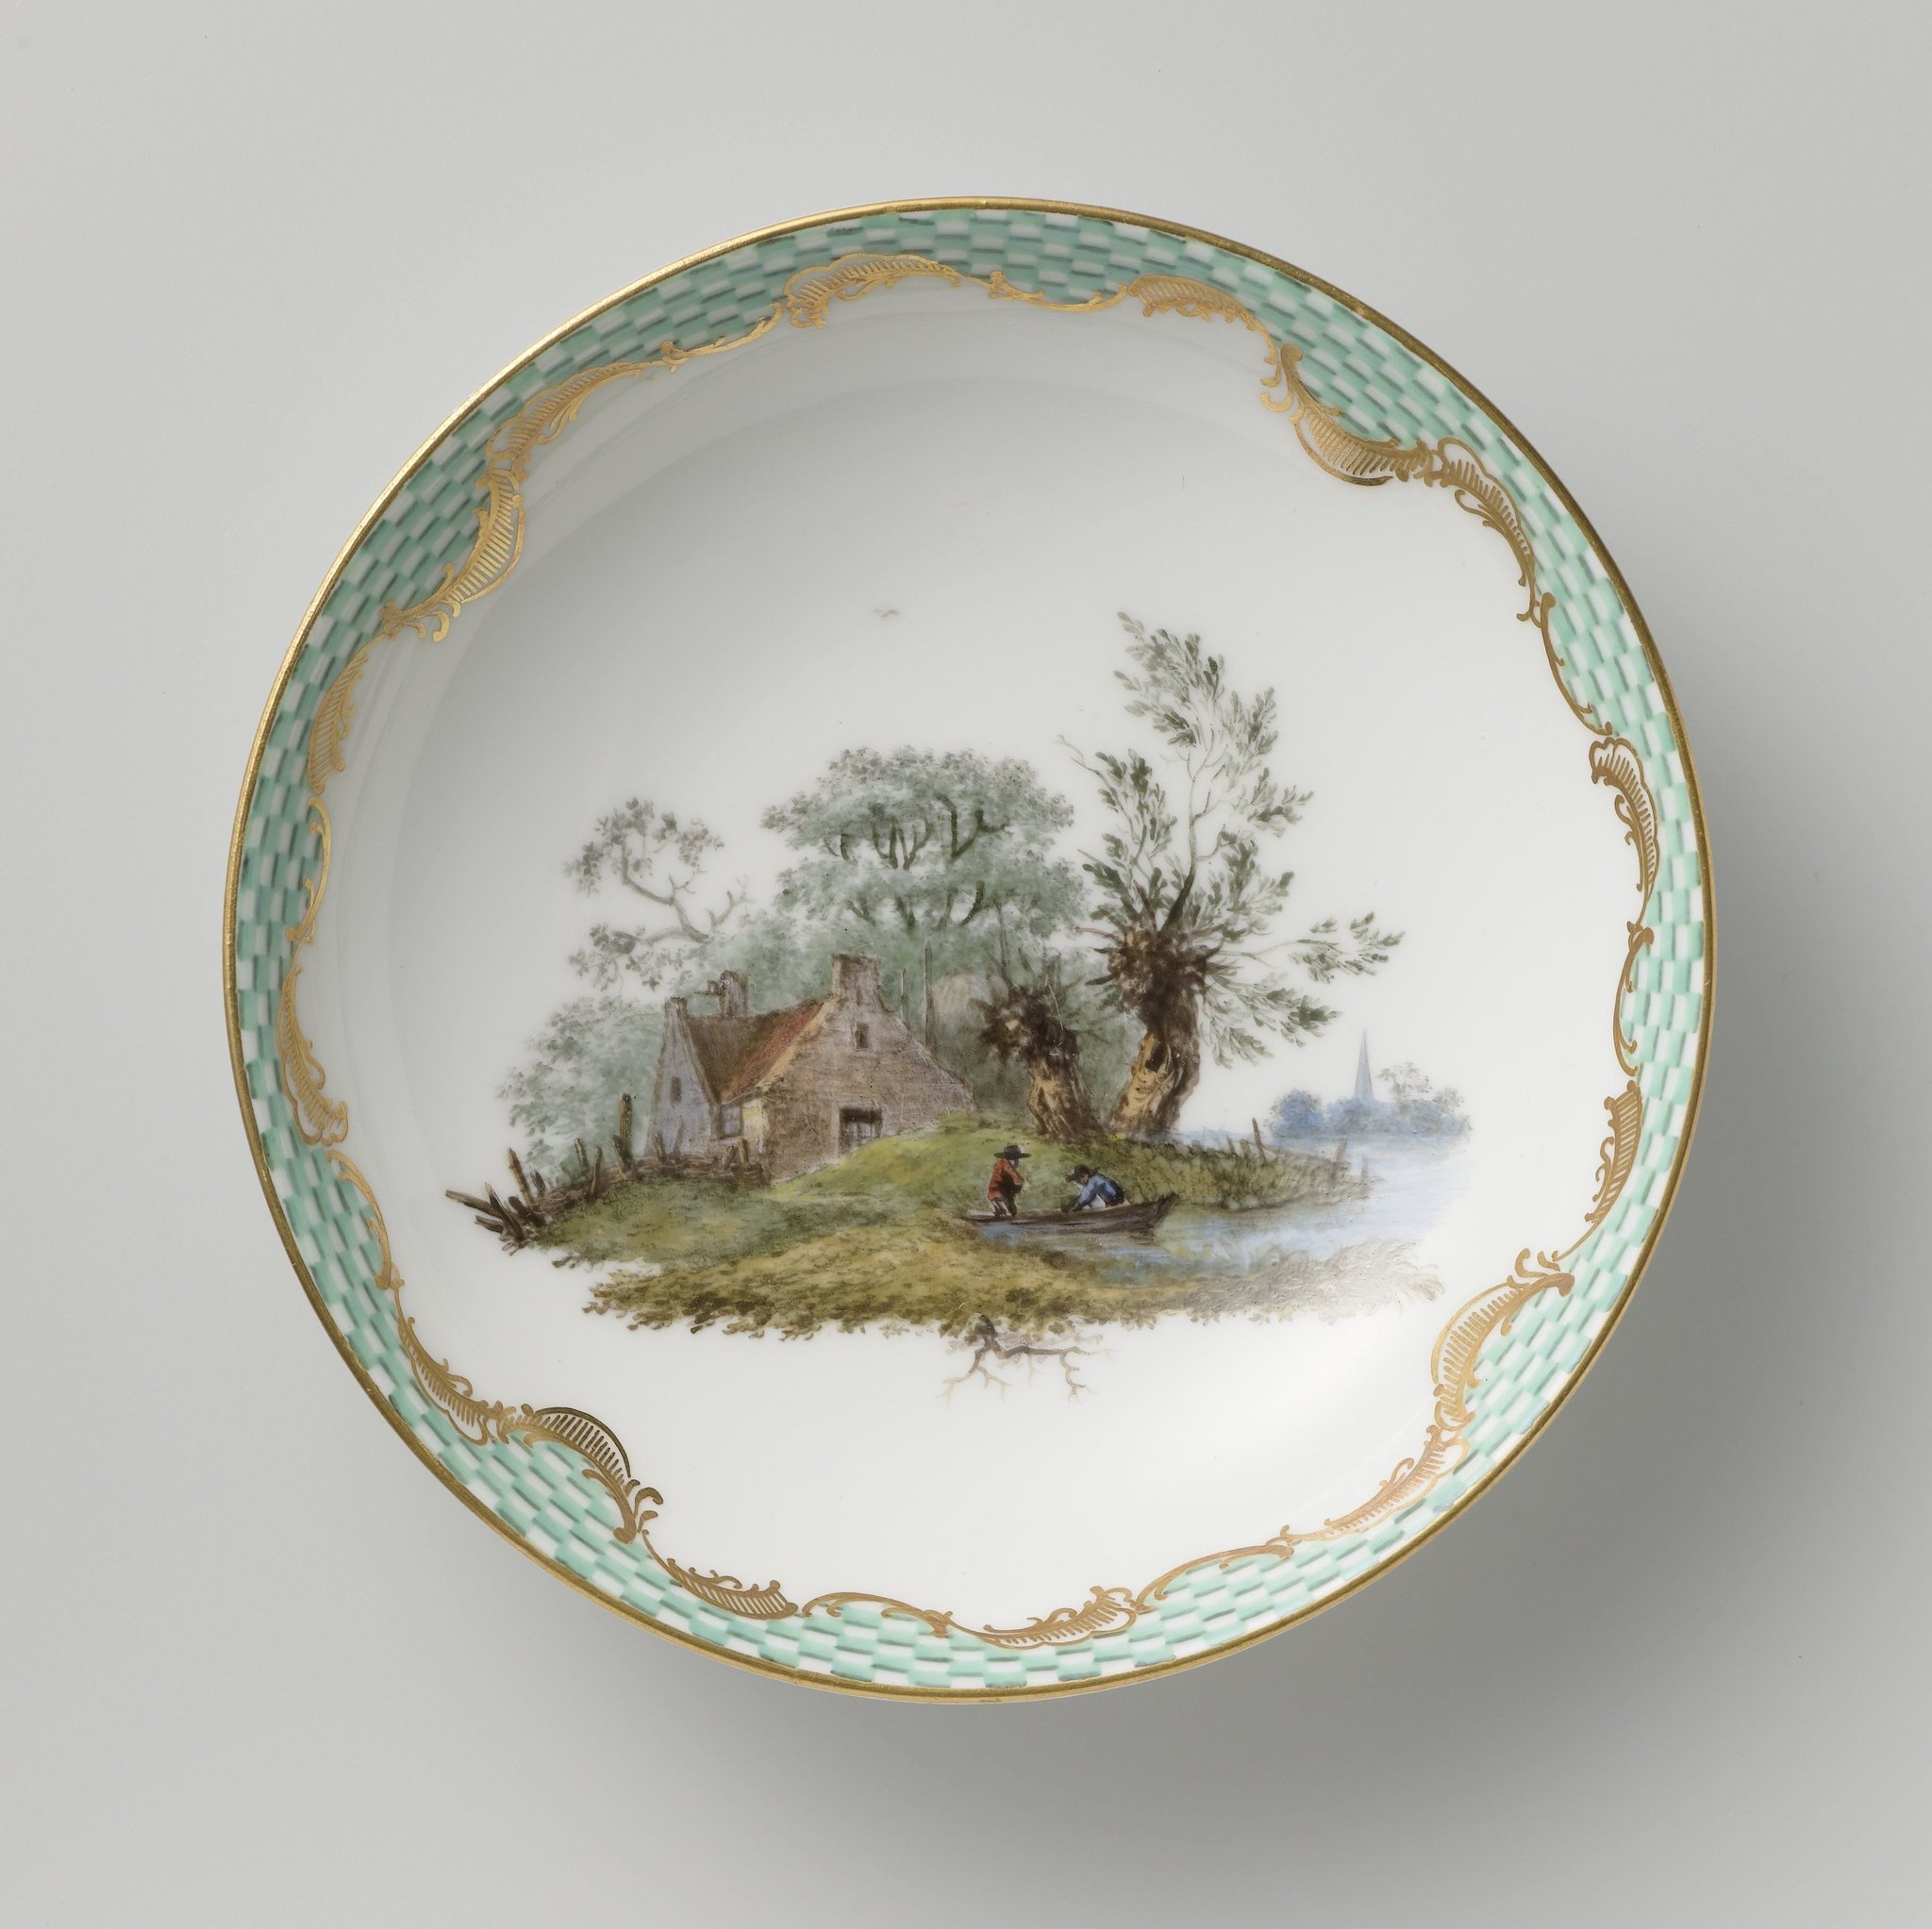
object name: platter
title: Schotel, veelkleurig beschilderd met een landschap met figuren.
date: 1777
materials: porcelain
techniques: painted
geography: meissen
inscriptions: mold mark, factory mark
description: Ronde schotel van beschilderd porselein. De schotel is beschilderd met landschappen waarin figuren en langs de rand een brede strook groen vlechtwerk. De schotel is gemerkt.